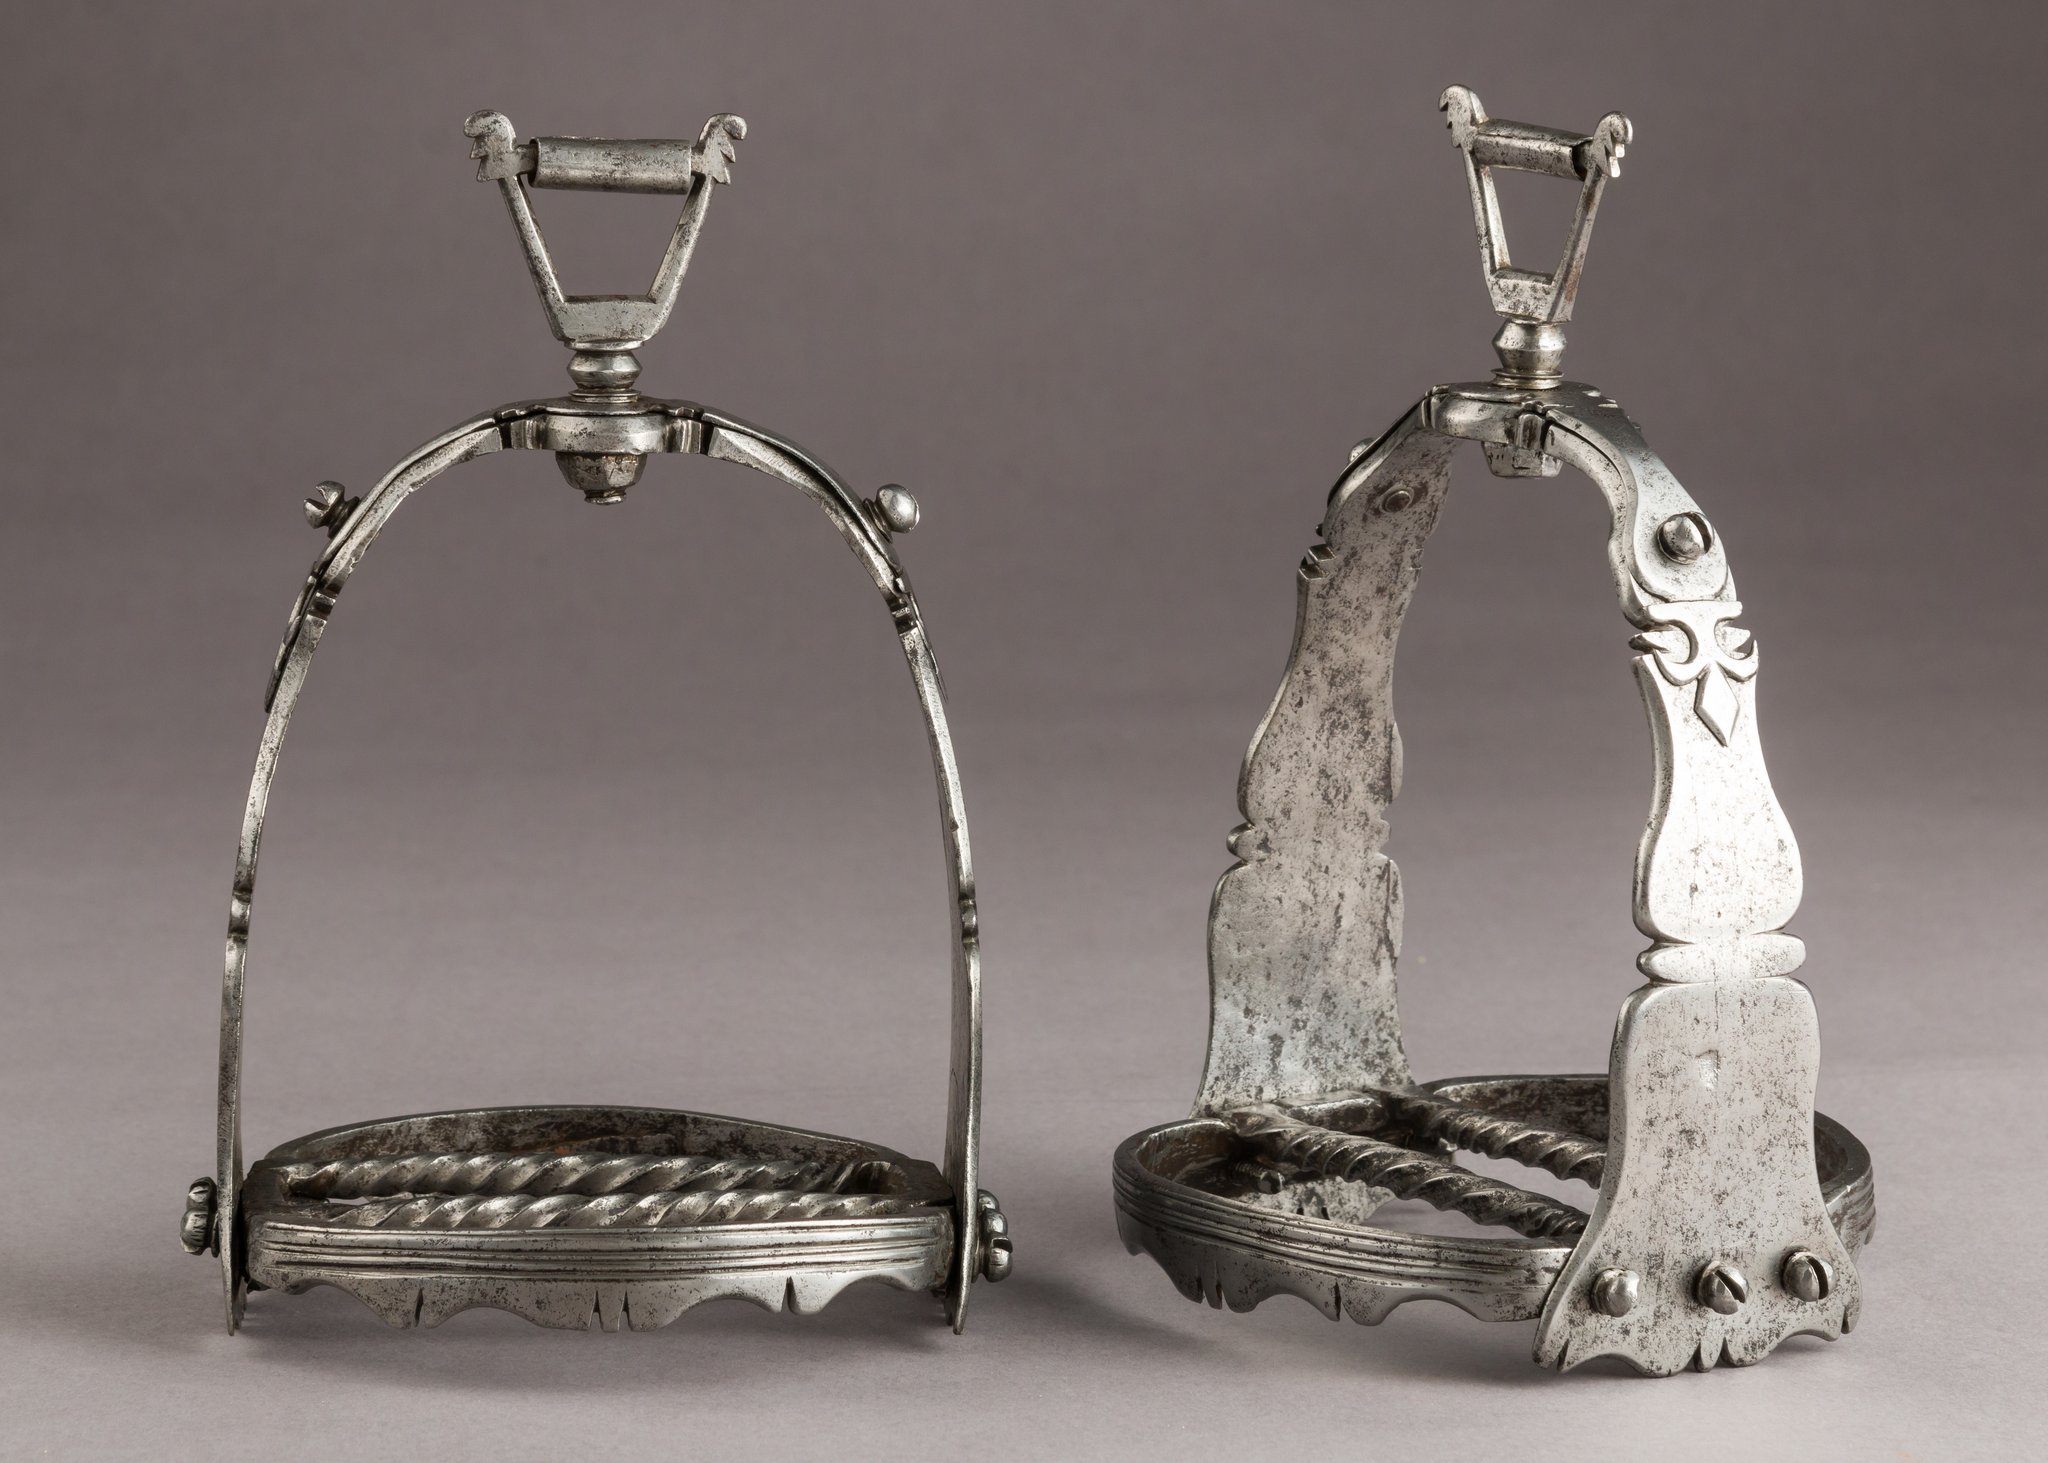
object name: stirrup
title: Pair of Stirrups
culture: dutch or german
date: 1634-1666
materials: copper, iron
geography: netherlands